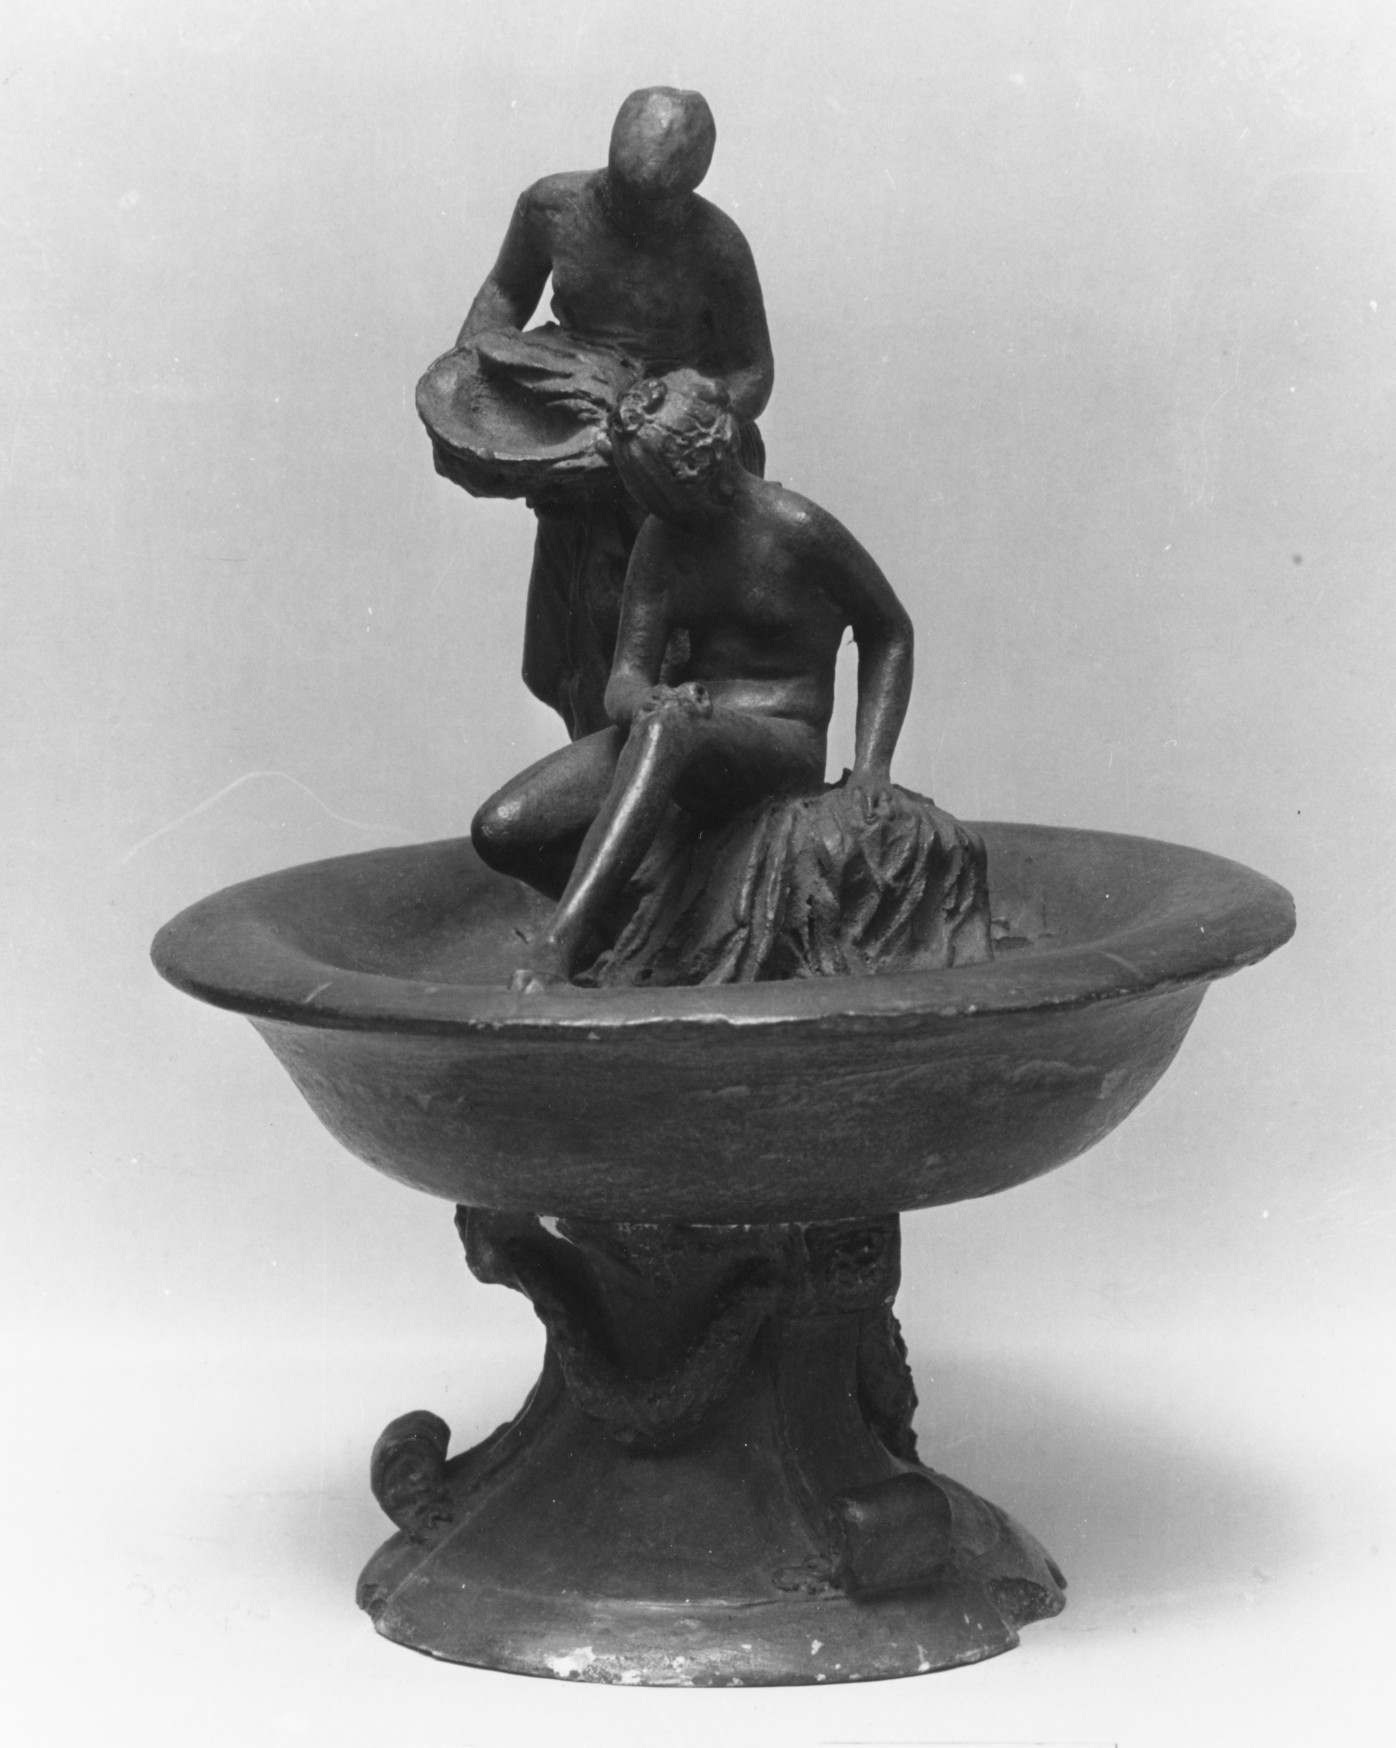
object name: fountain model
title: The Bather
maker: jean antoine houdon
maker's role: artist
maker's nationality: french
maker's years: 1741-1828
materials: terracotta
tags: women,female nudes,bathing